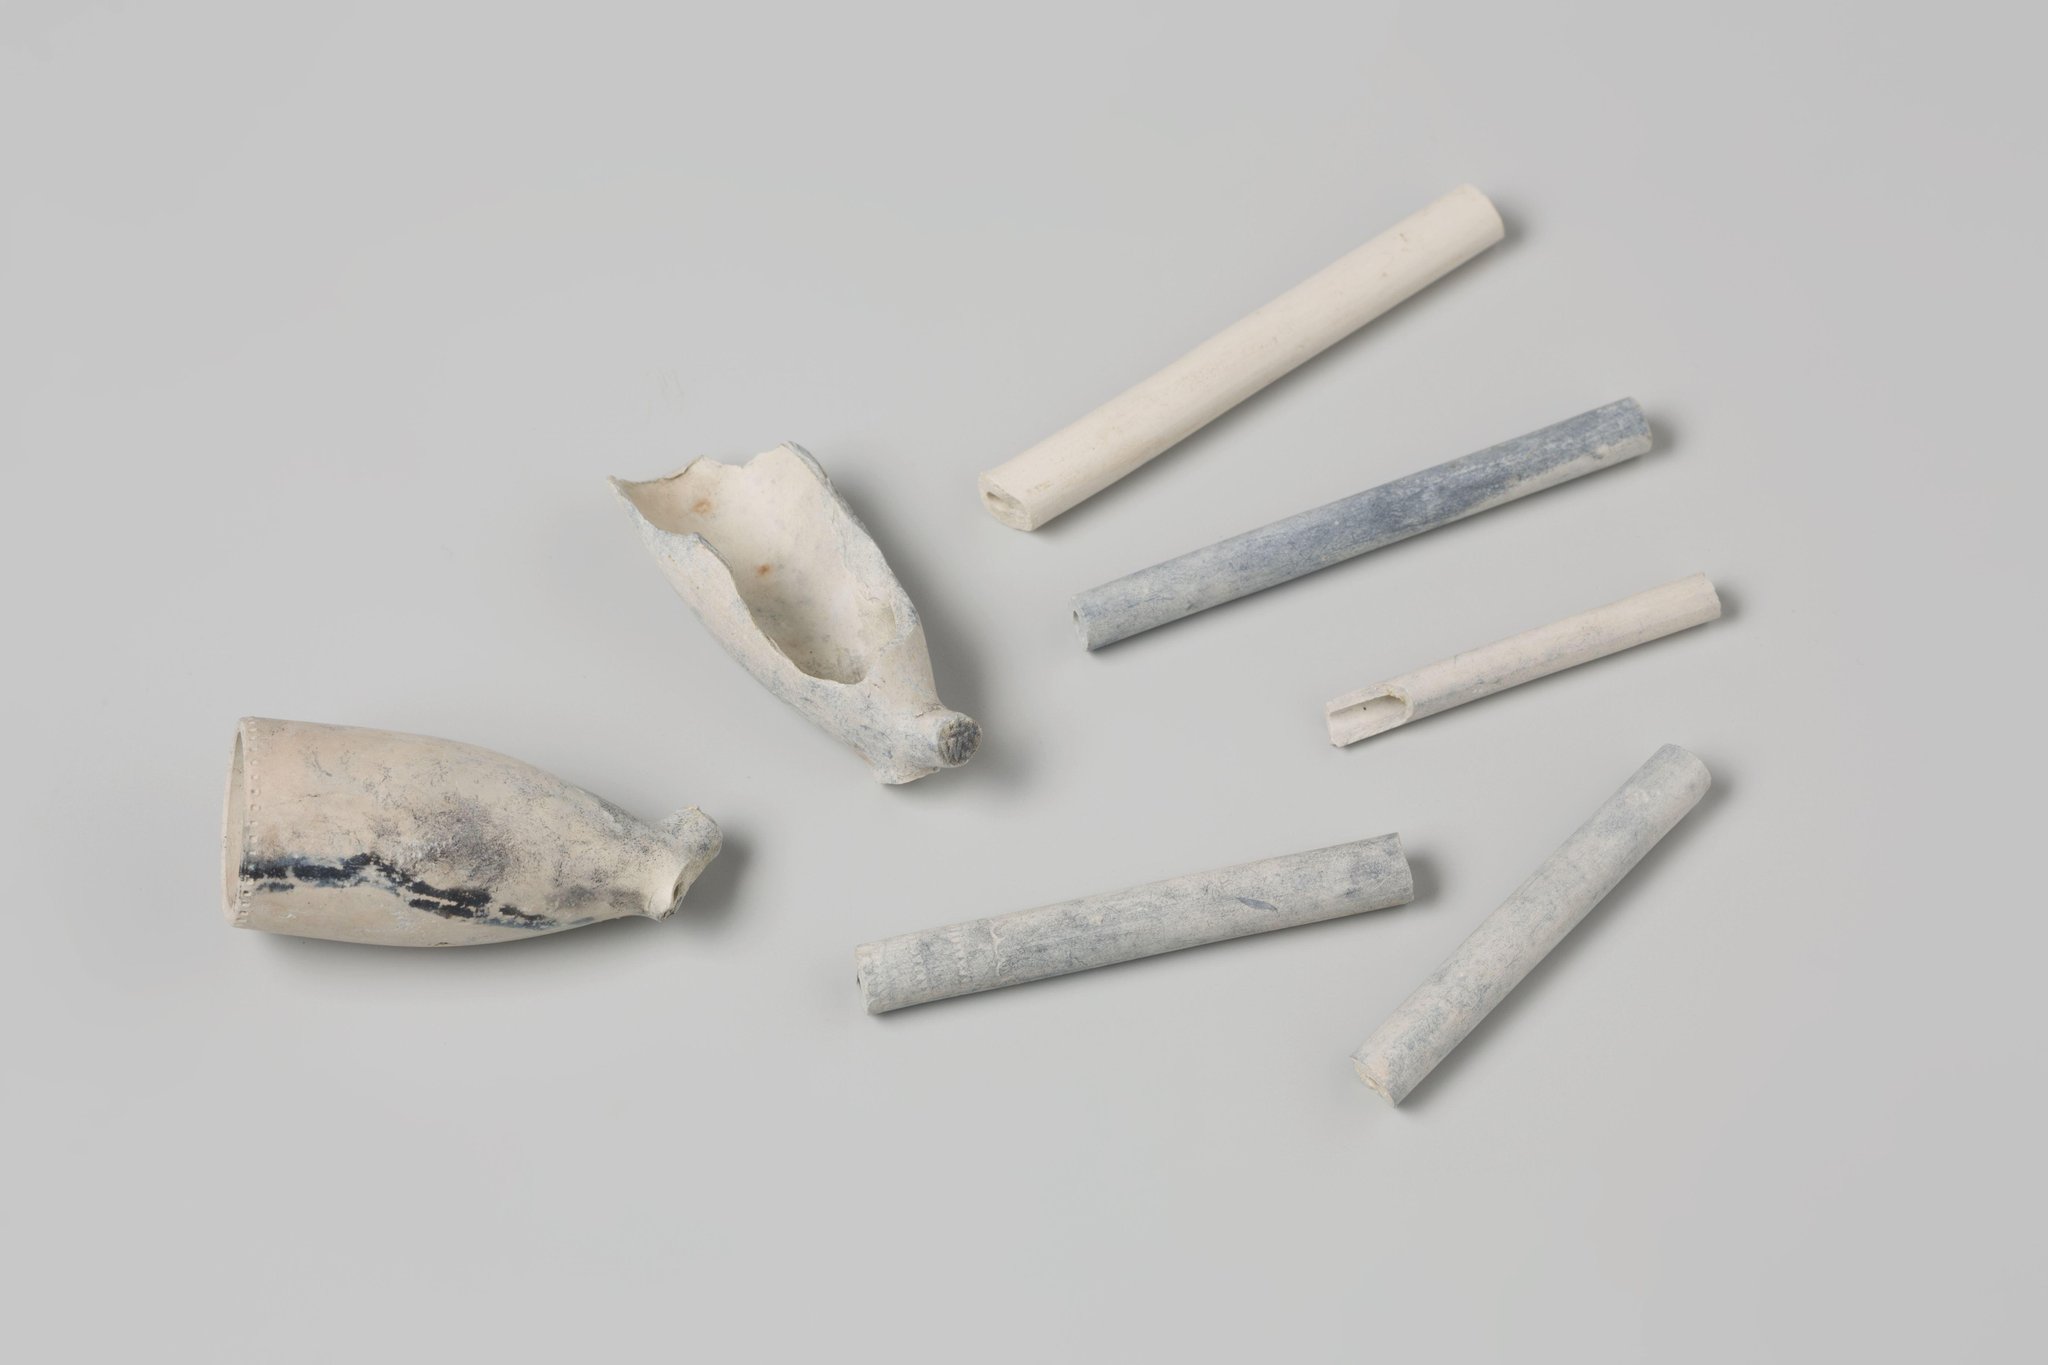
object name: pipe bowl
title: Fragmenten van pijpenkoppen en pijpenstelen uit het wrak van de Oost-Indiëvaarder 't Vliegend Hart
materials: clay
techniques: firing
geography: gouda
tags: 't vliegend hart (schip), verenigde oostindische compagnie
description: Twee koppen van aarden Goudse pijpen: beide met hielmerk gekroonde WS, waarvan éen gebroken. Vijf stukken steel. Fragments of bowls and stems.